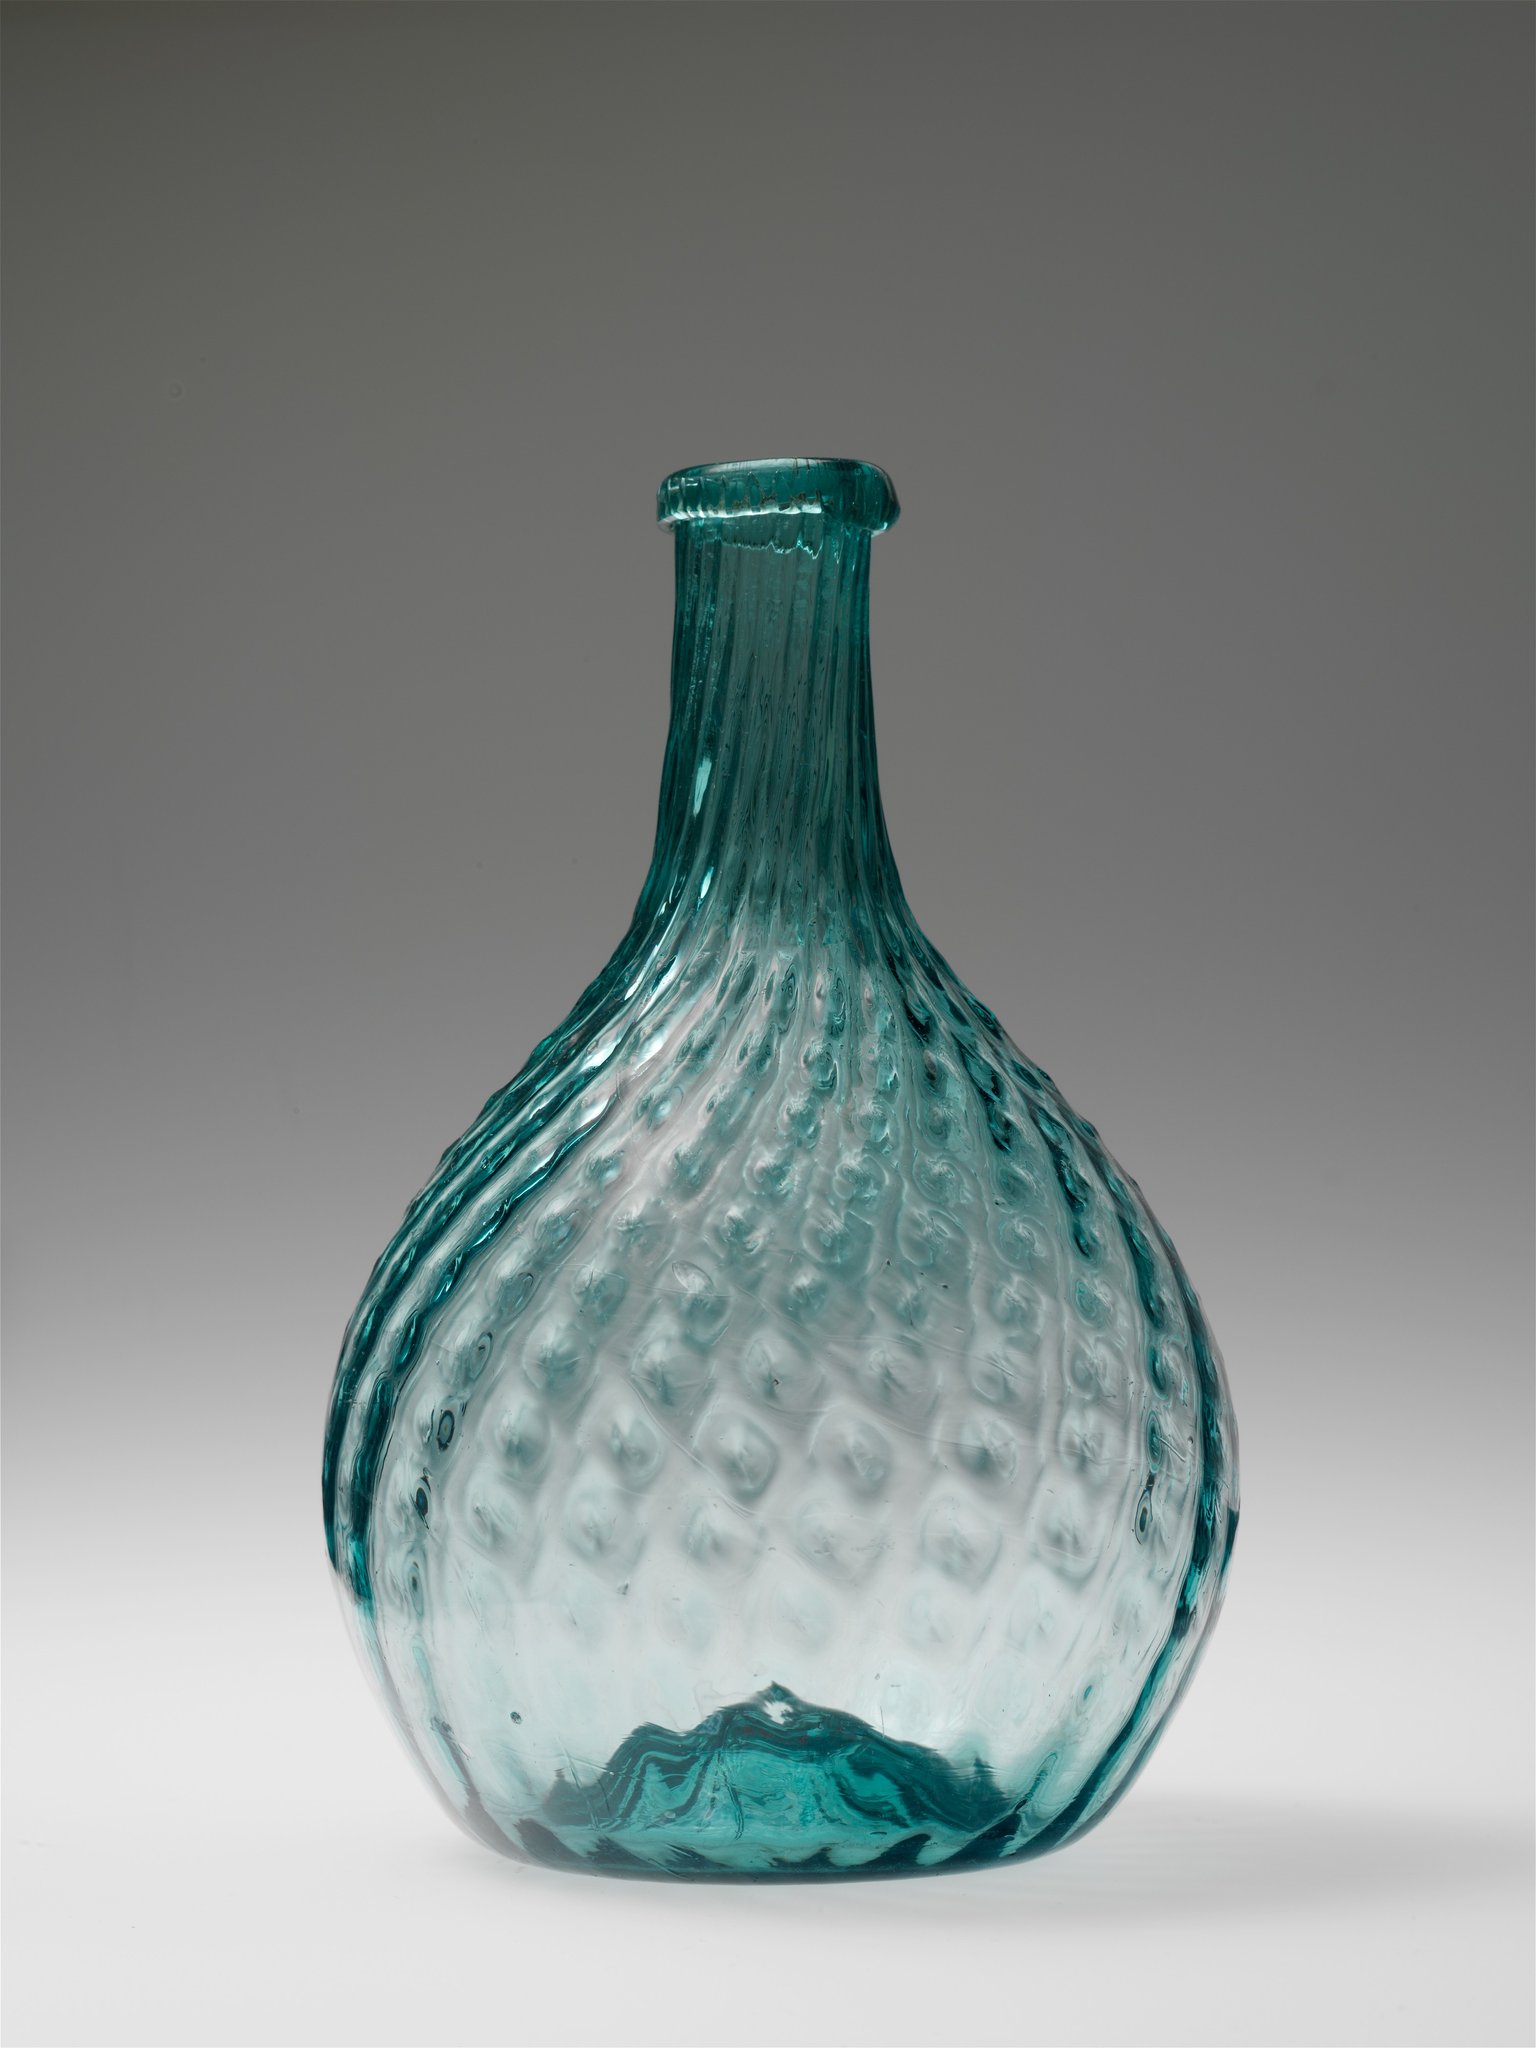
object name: bottle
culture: american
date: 1815-1845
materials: glass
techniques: glassblowing, molding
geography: united states